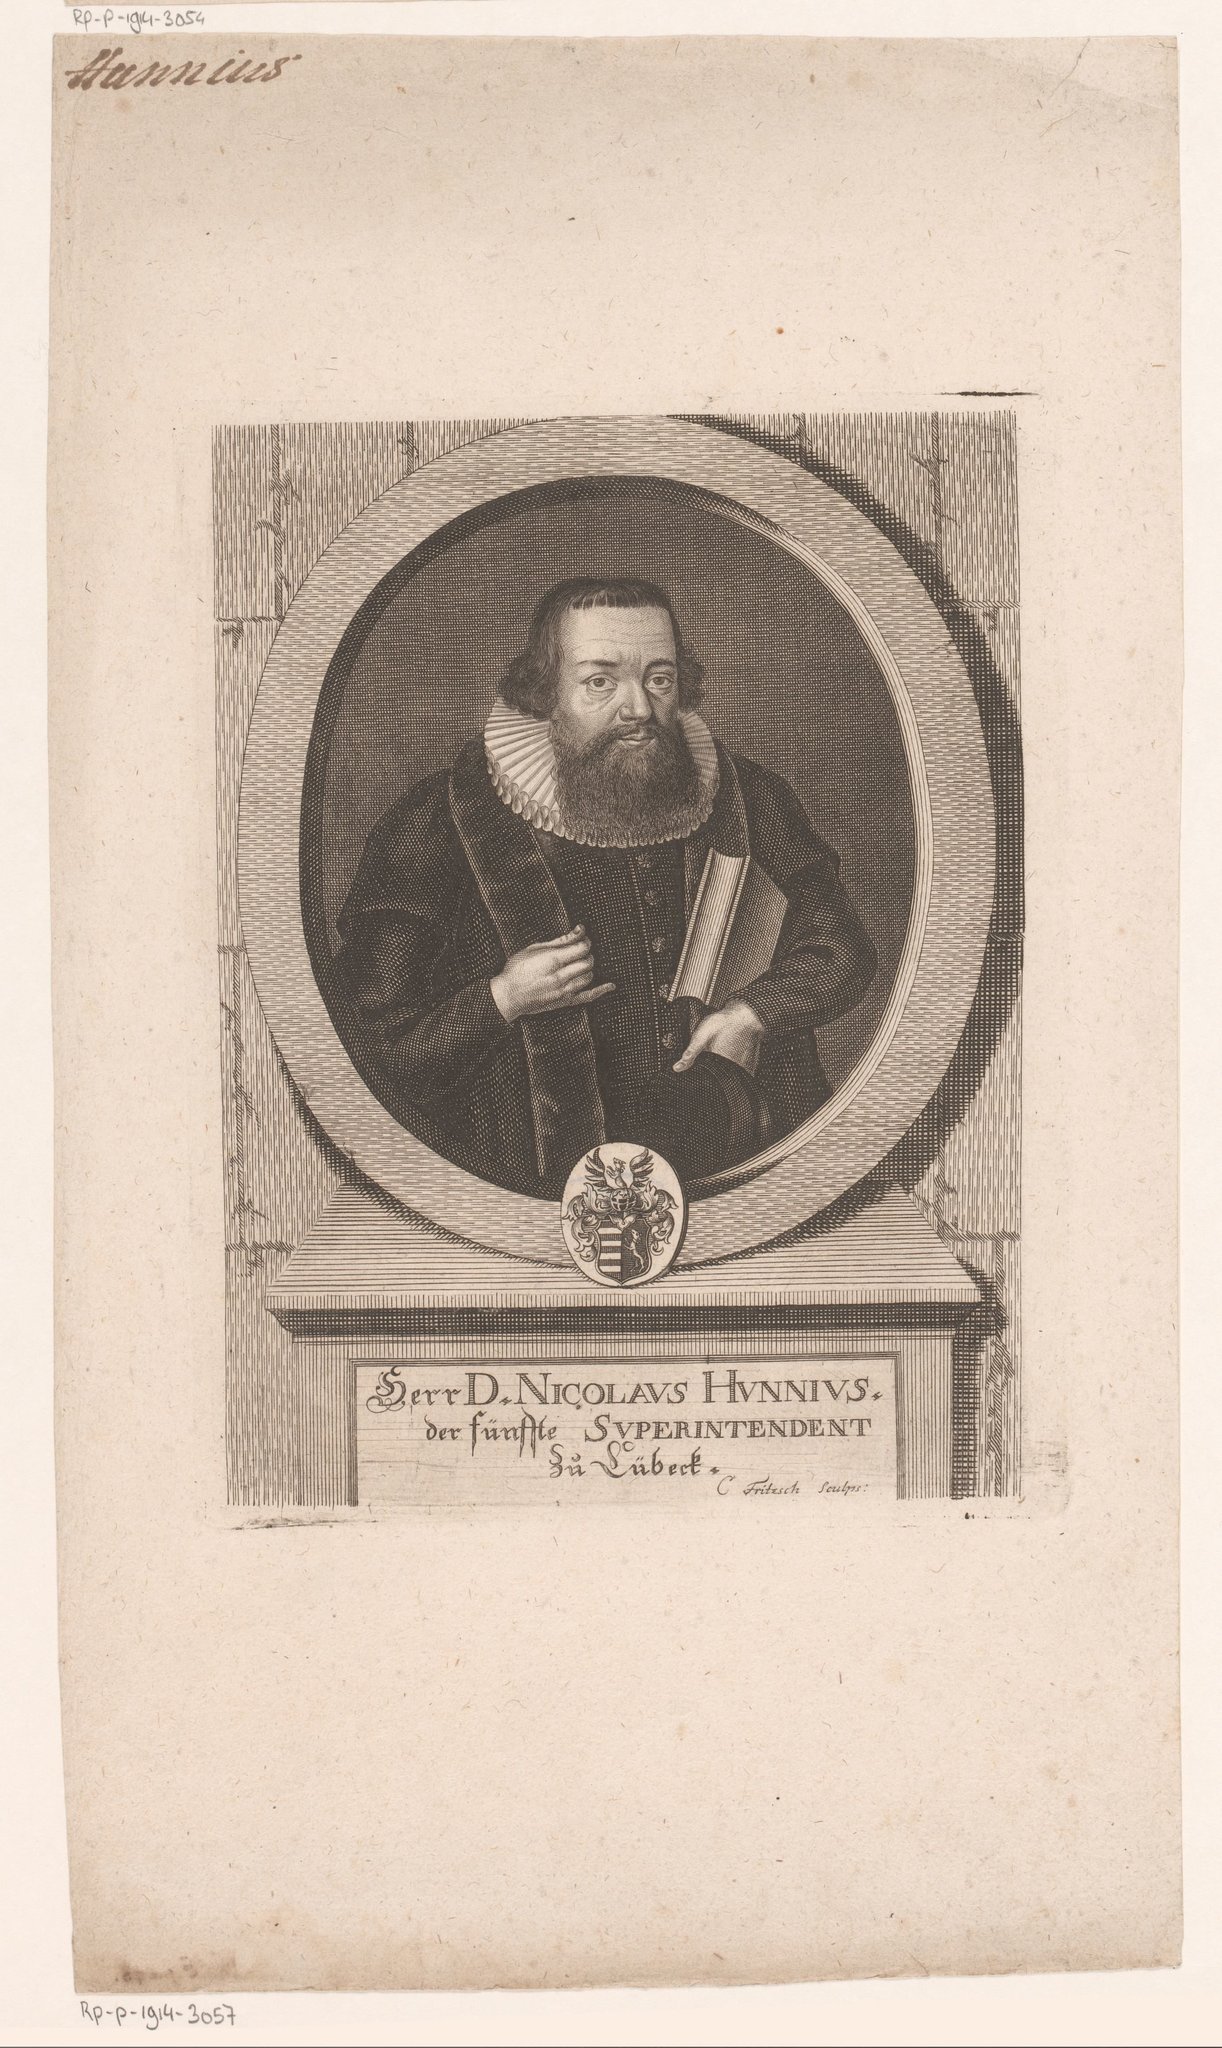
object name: print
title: Portret van Nikolaus Hunnius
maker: christian fritzsch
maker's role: print maker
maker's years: 1695-1769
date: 1705-1769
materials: paper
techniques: engraving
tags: theologian, ornament ~ medallion, historical persons, armorial bearing, heraldry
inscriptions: collector's mark: Lugt 2228